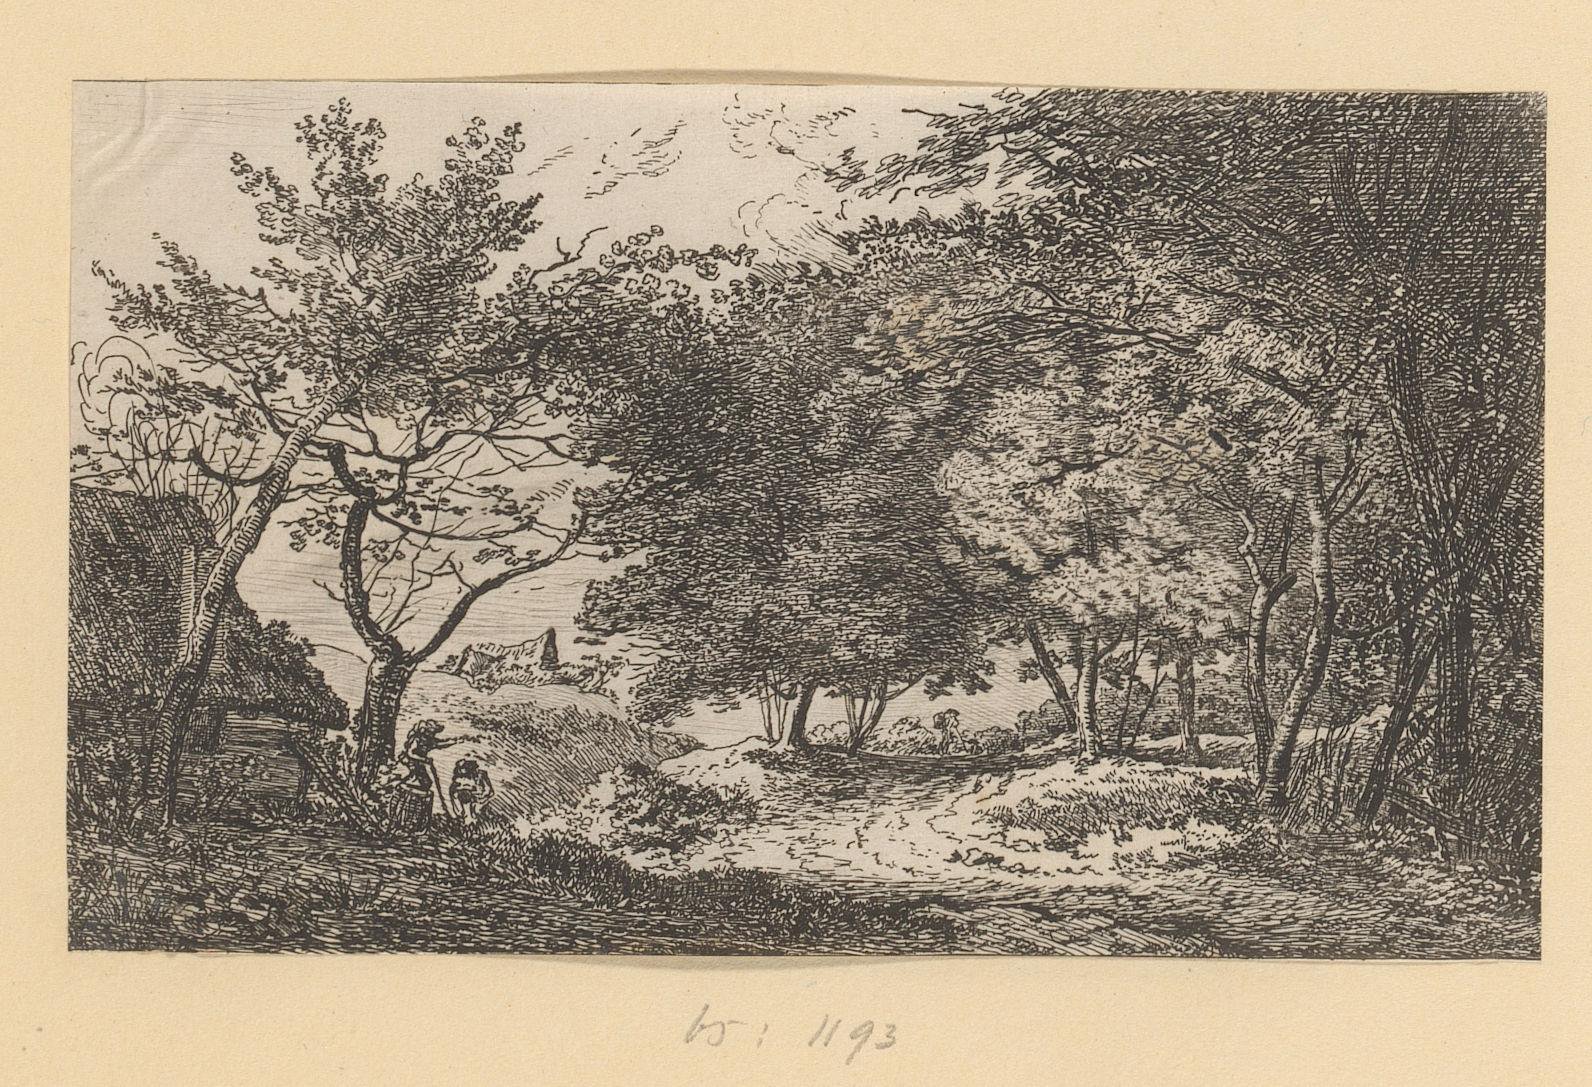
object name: album leaf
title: Twenty rural landscapes from nature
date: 1793-1795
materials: paper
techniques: etching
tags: landscapes (+ landscape with figures, staffage), farm (building)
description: Deze prent hoort bij een serie van 20 prenten. Prent maakt mogelijk deel uit van een serie van 200 prenten. Deze serie is onder de titel 'A Collection of two hundred original etchings' voor het eerst uitgegeven door J.M. Greery in 1816.